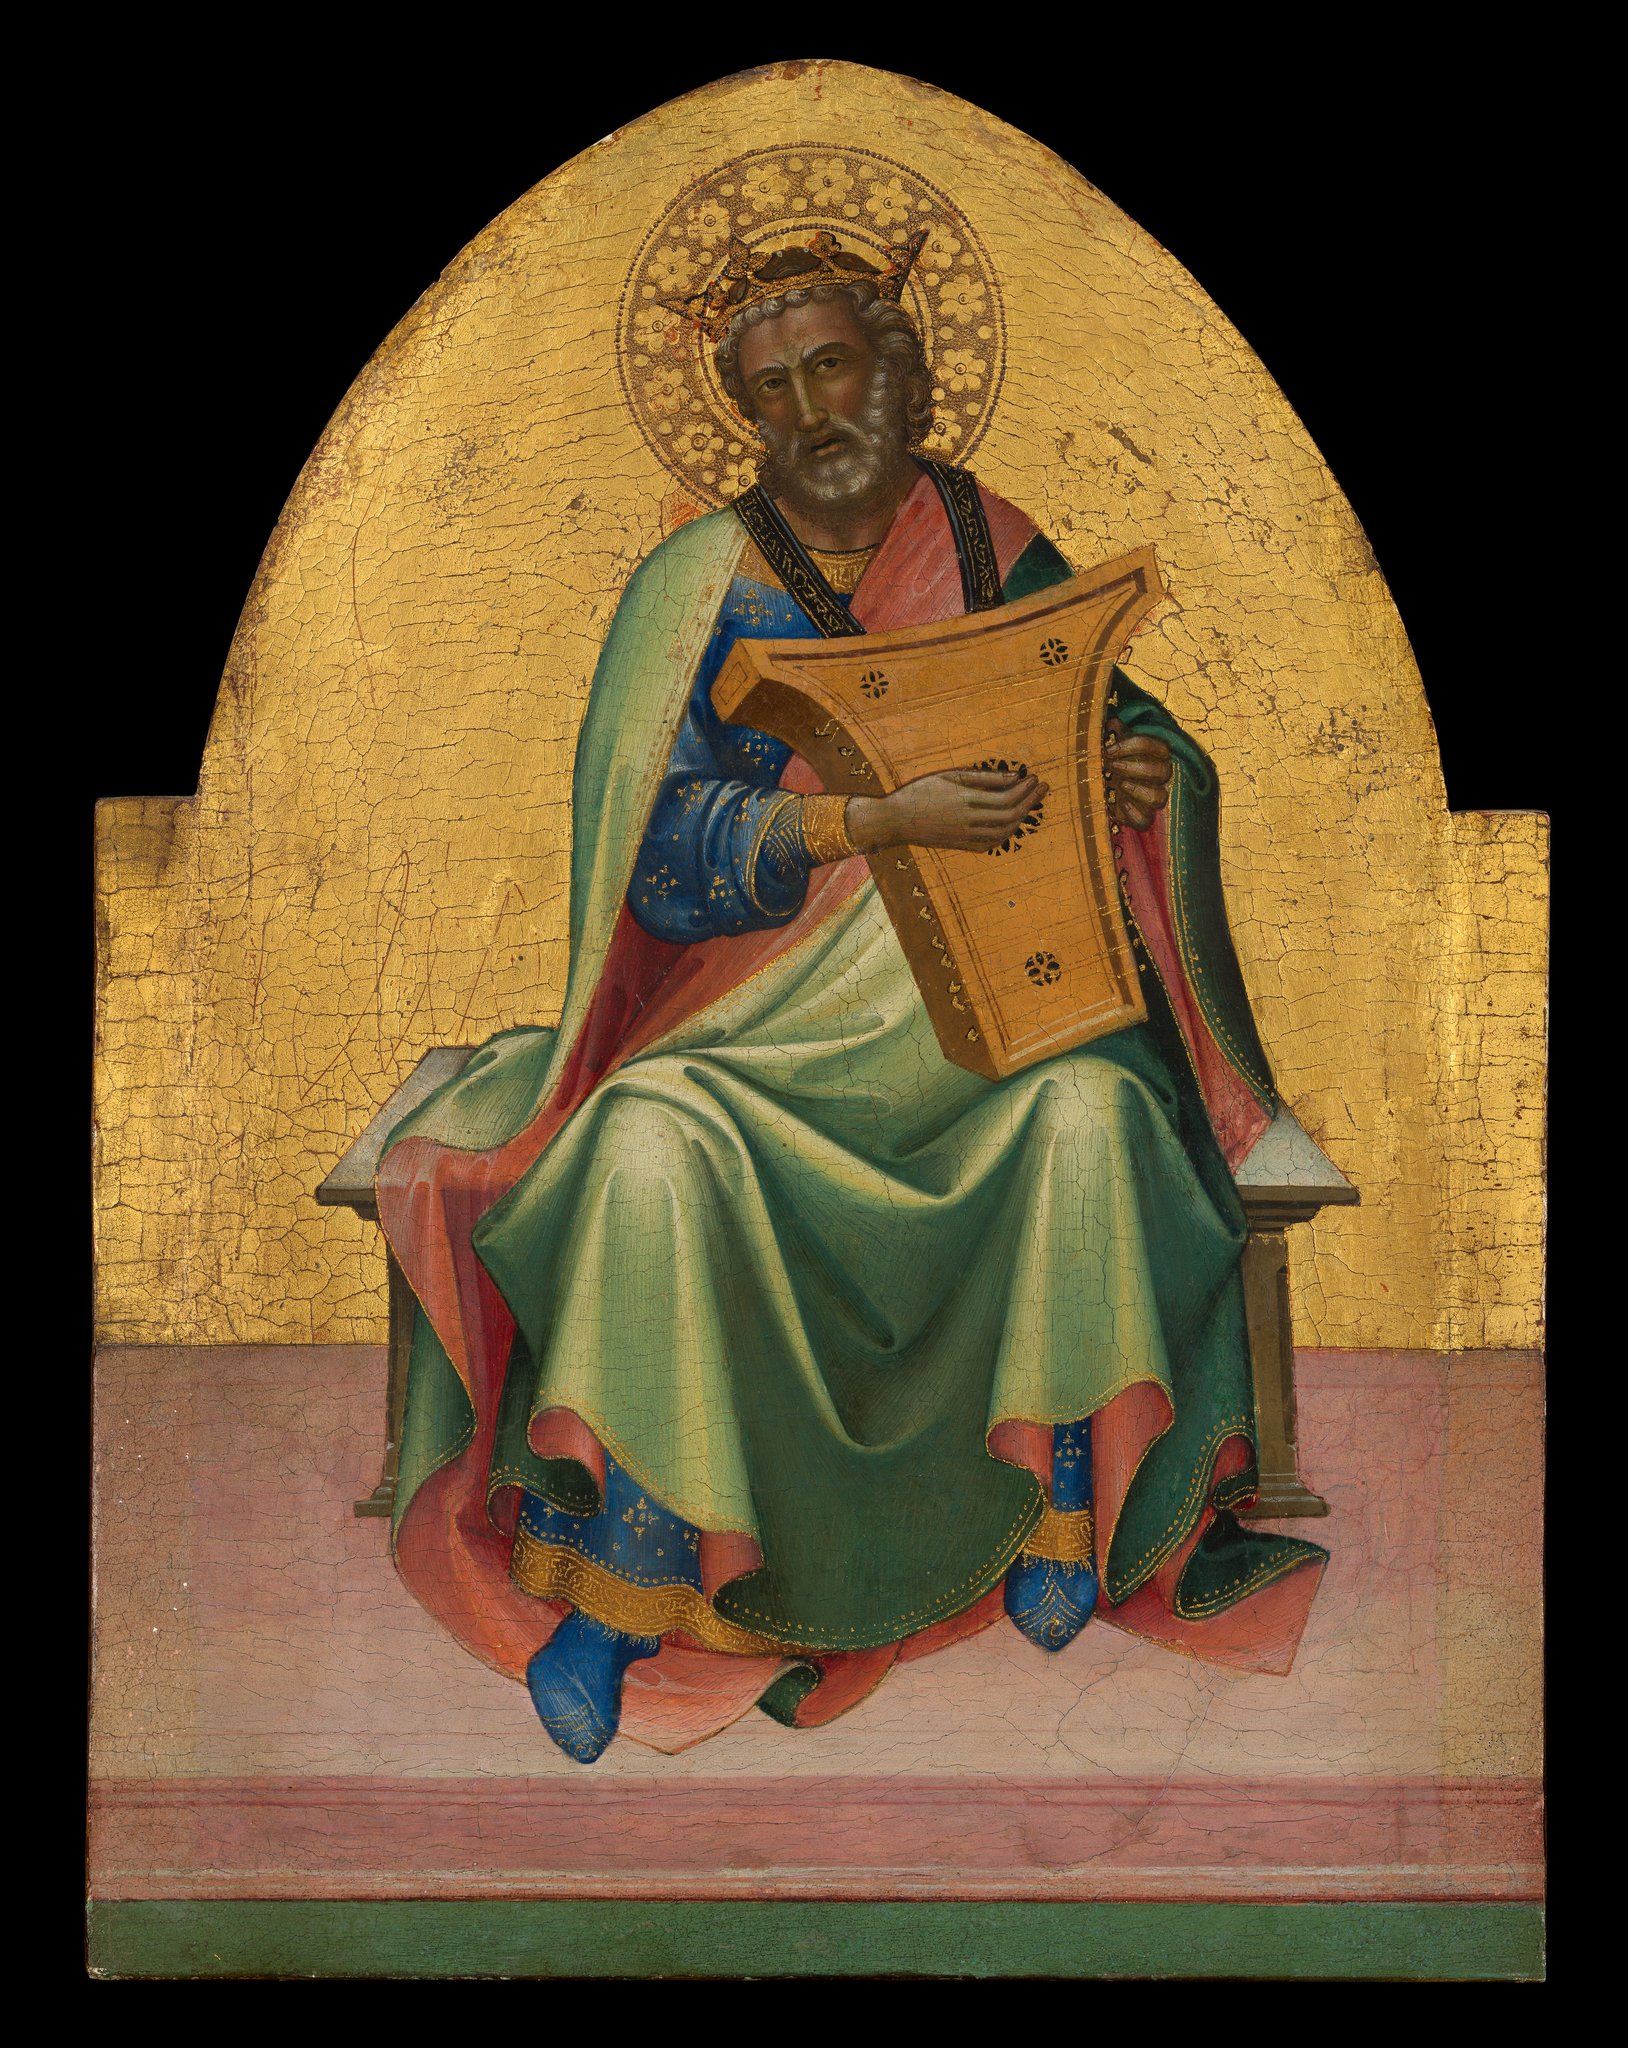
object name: painting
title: David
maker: lorenzo monaco (piero di giovanni)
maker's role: artist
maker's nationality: italian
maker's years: 1370-1425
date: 1408-1410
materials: gold leaf, paint, wood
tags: musical instruments,david